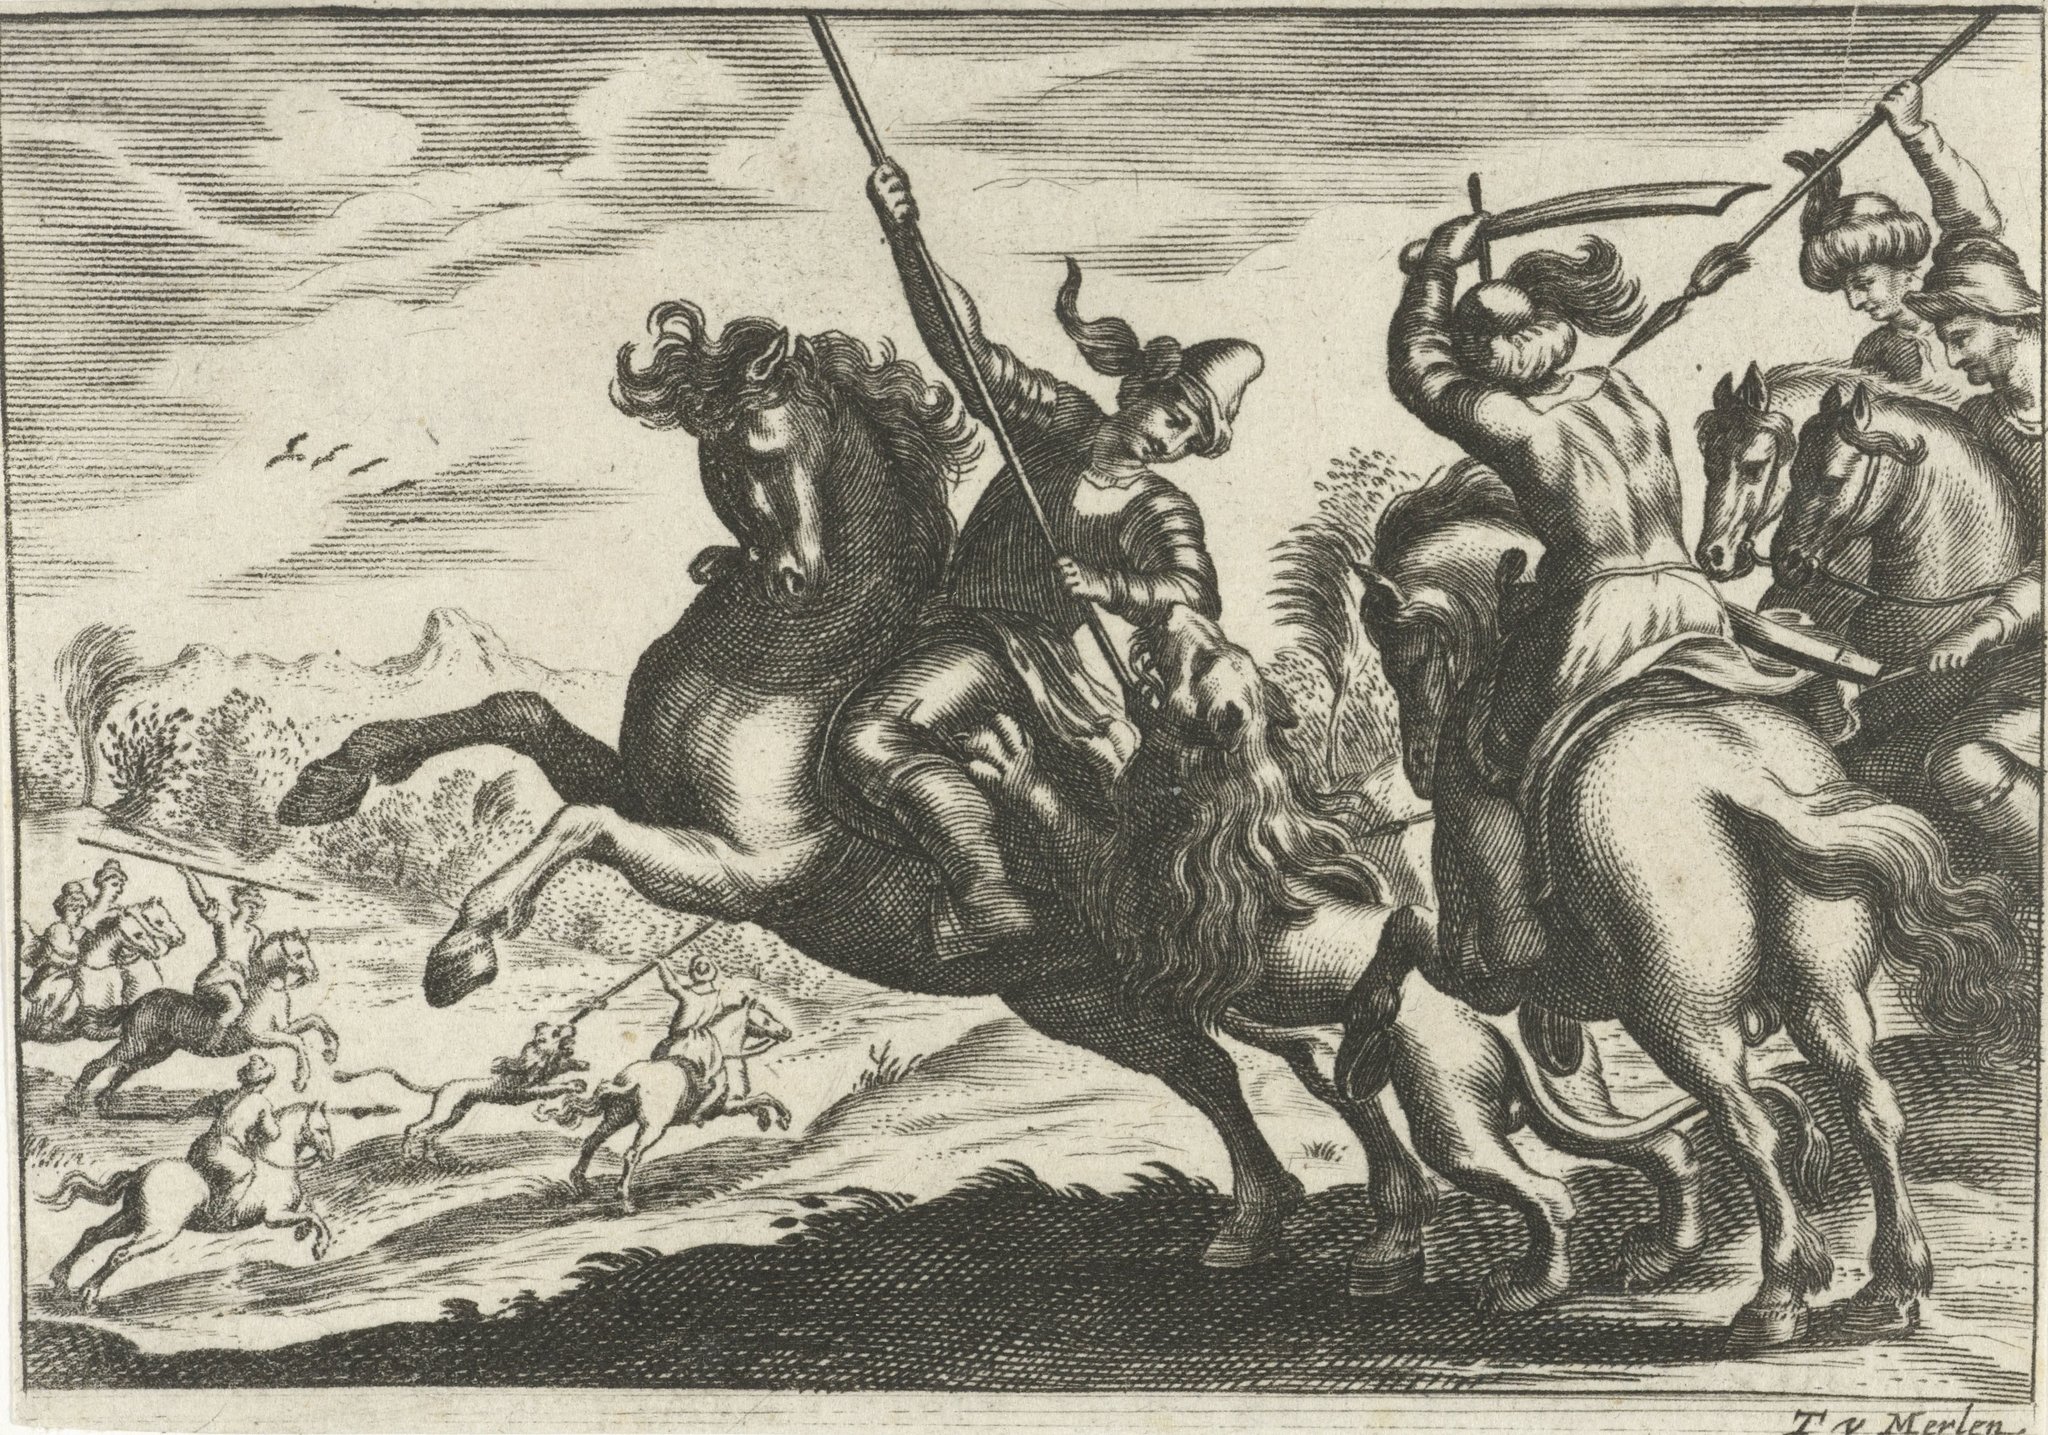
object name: print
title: Leeuwenjacht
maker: theodor van merlen (ii)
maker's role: print maker, publisher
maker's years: 1609-1672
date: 1619-1672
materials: paper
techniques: engraving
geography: antwerp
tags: lion hunt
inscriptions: collector's mark: Lugt 2228